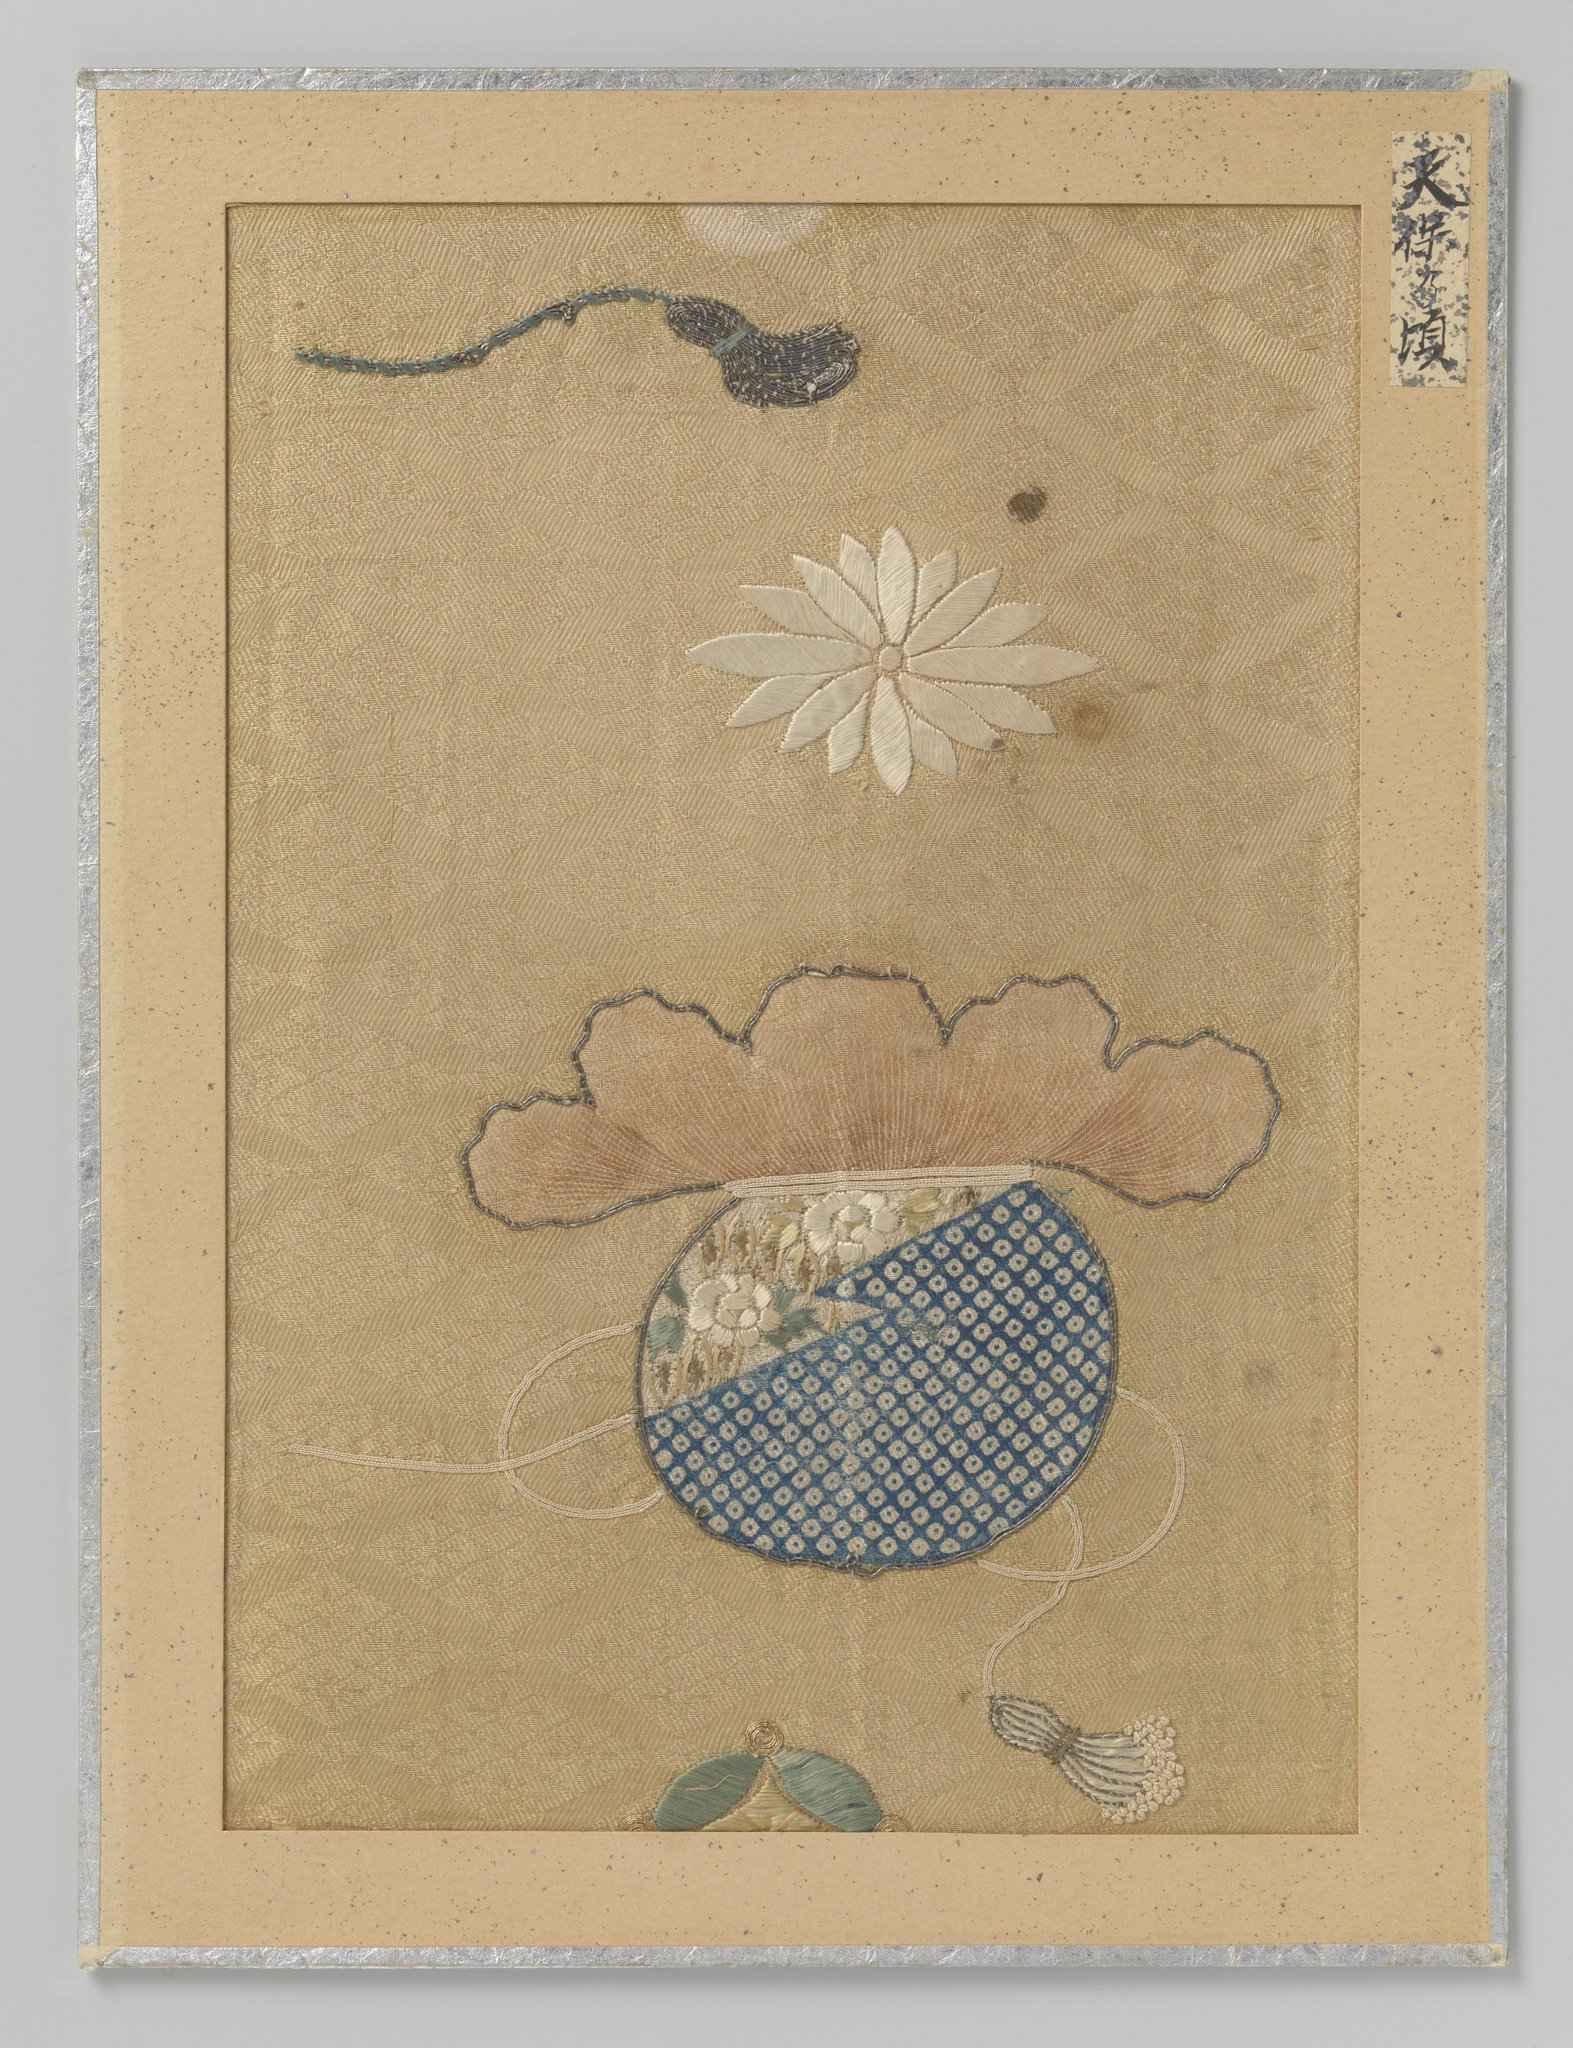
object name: fragment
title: Textielfragment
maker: Anonymous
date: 1830-1844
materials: silk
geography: japan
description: Textielfragment, borduursel en druk van een brocaatzakje en bloem op beige damast achtergrond.